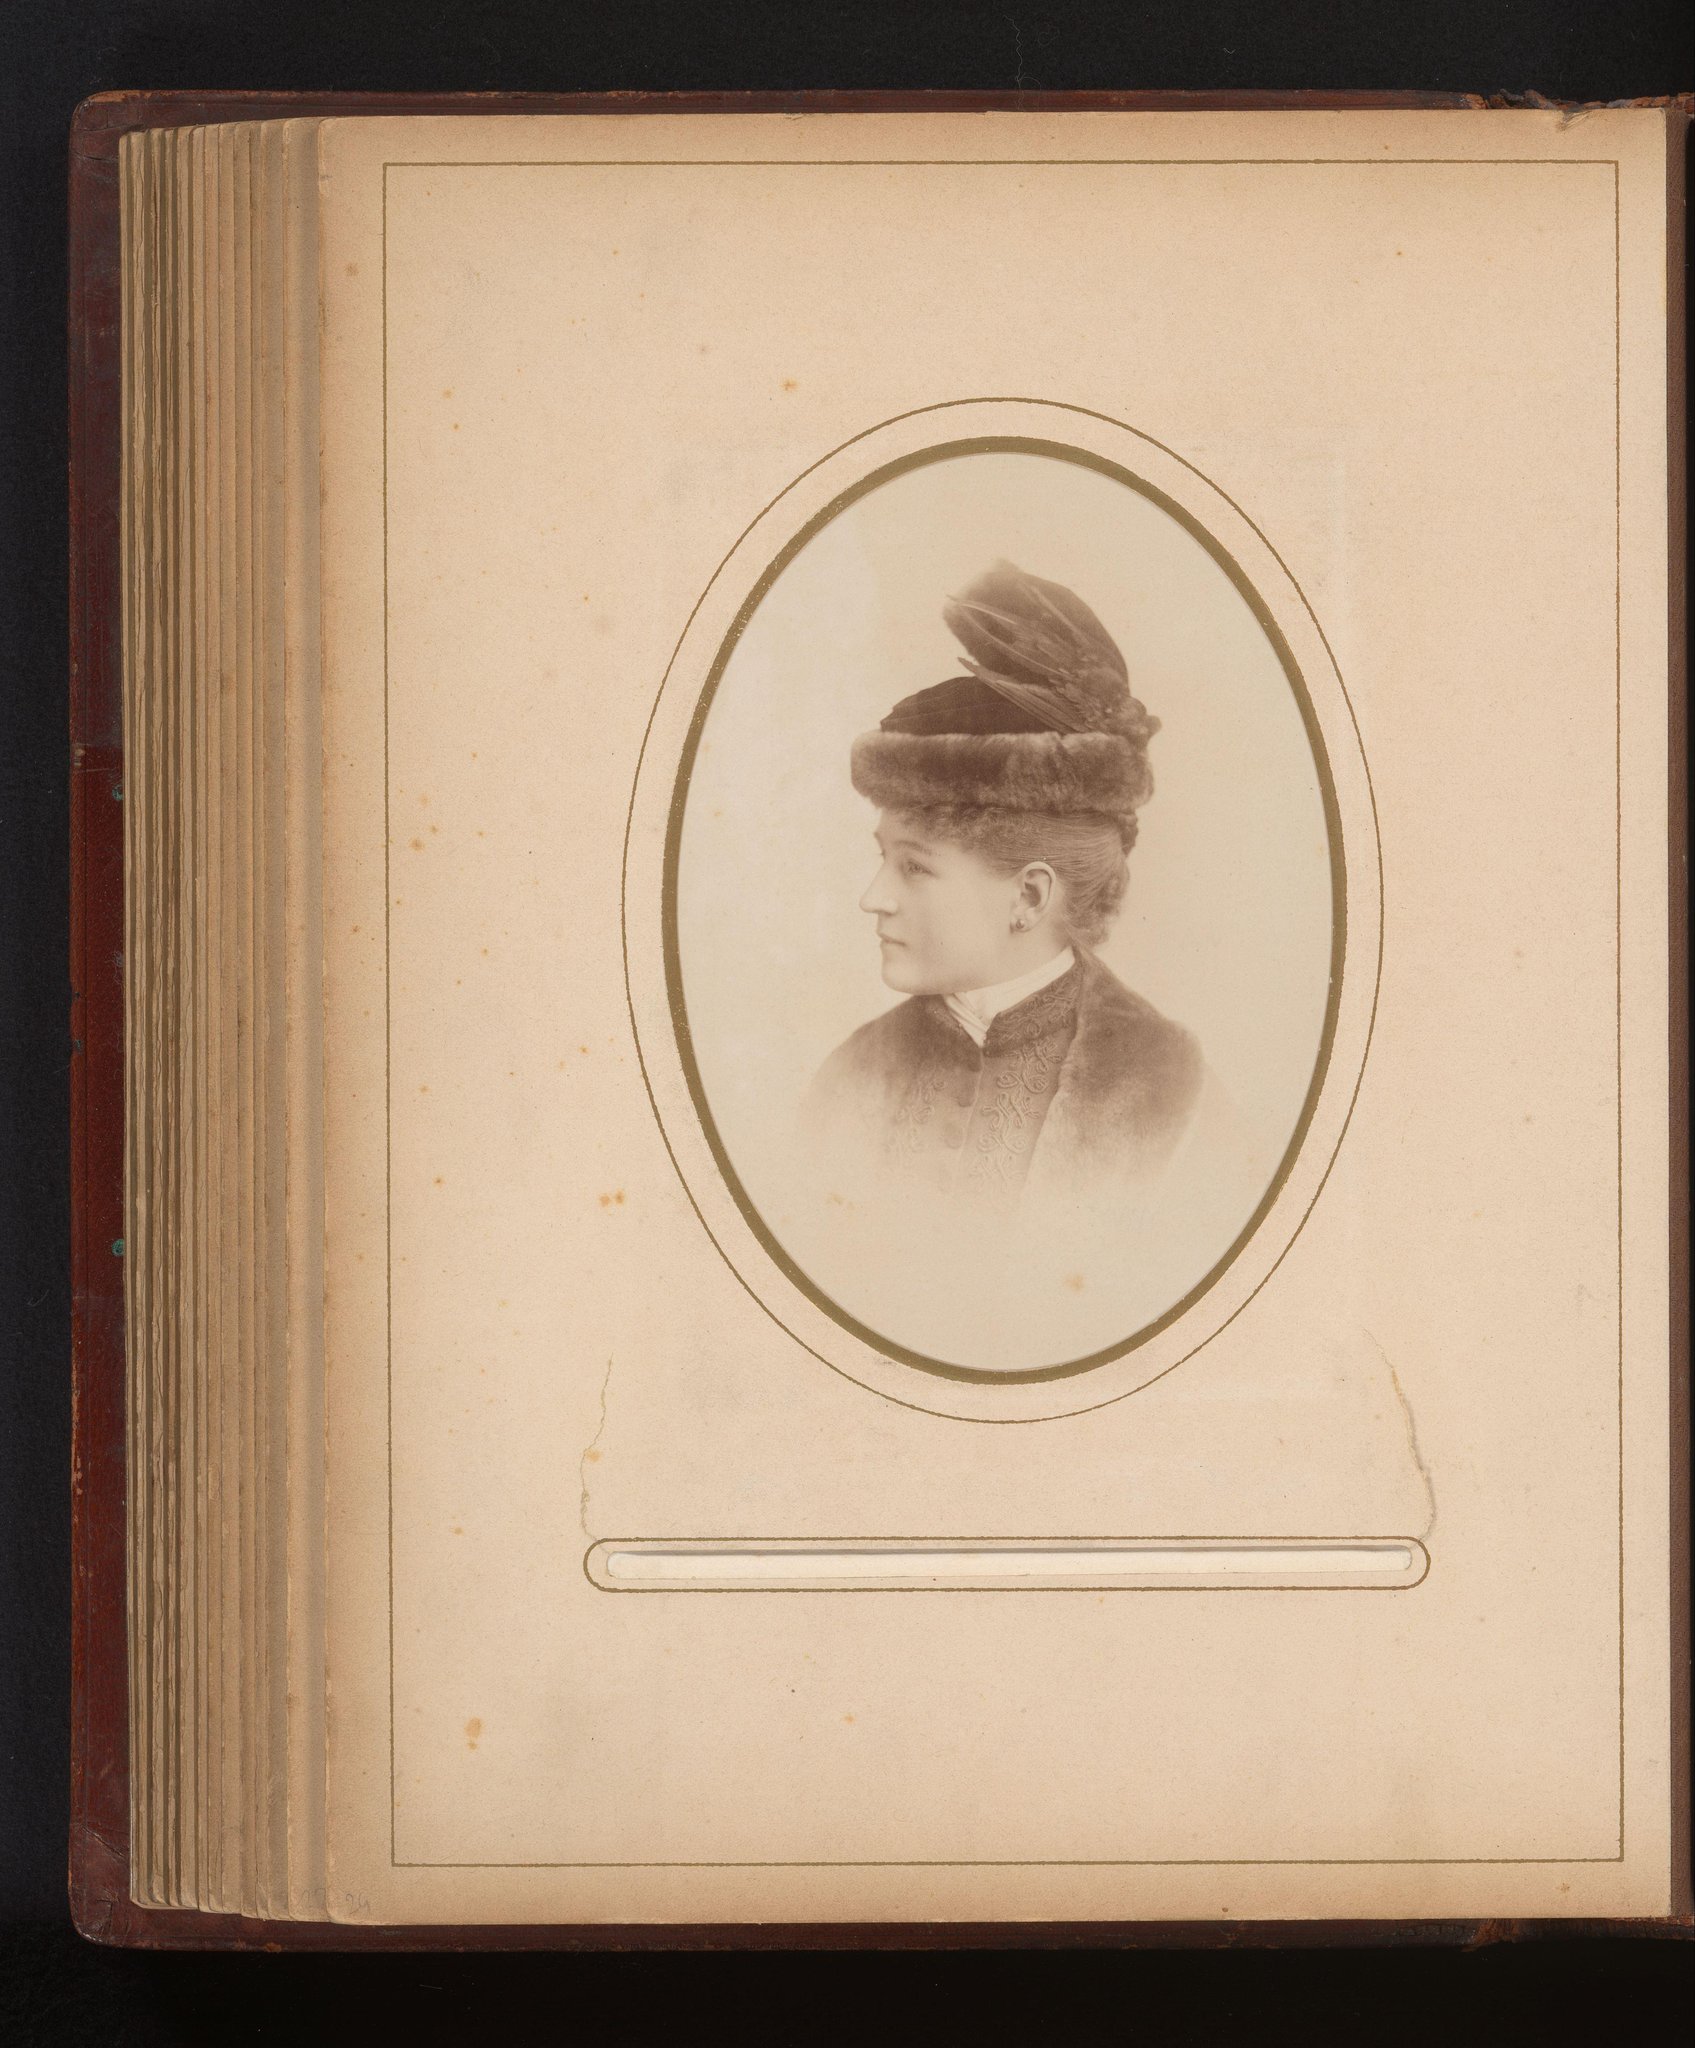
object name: album leaf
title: Portret van een vrouw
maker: Anonymous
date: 1860-1900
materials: cardboard, photographic support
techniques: albumen print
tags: adult woman, head-gear, historical persons